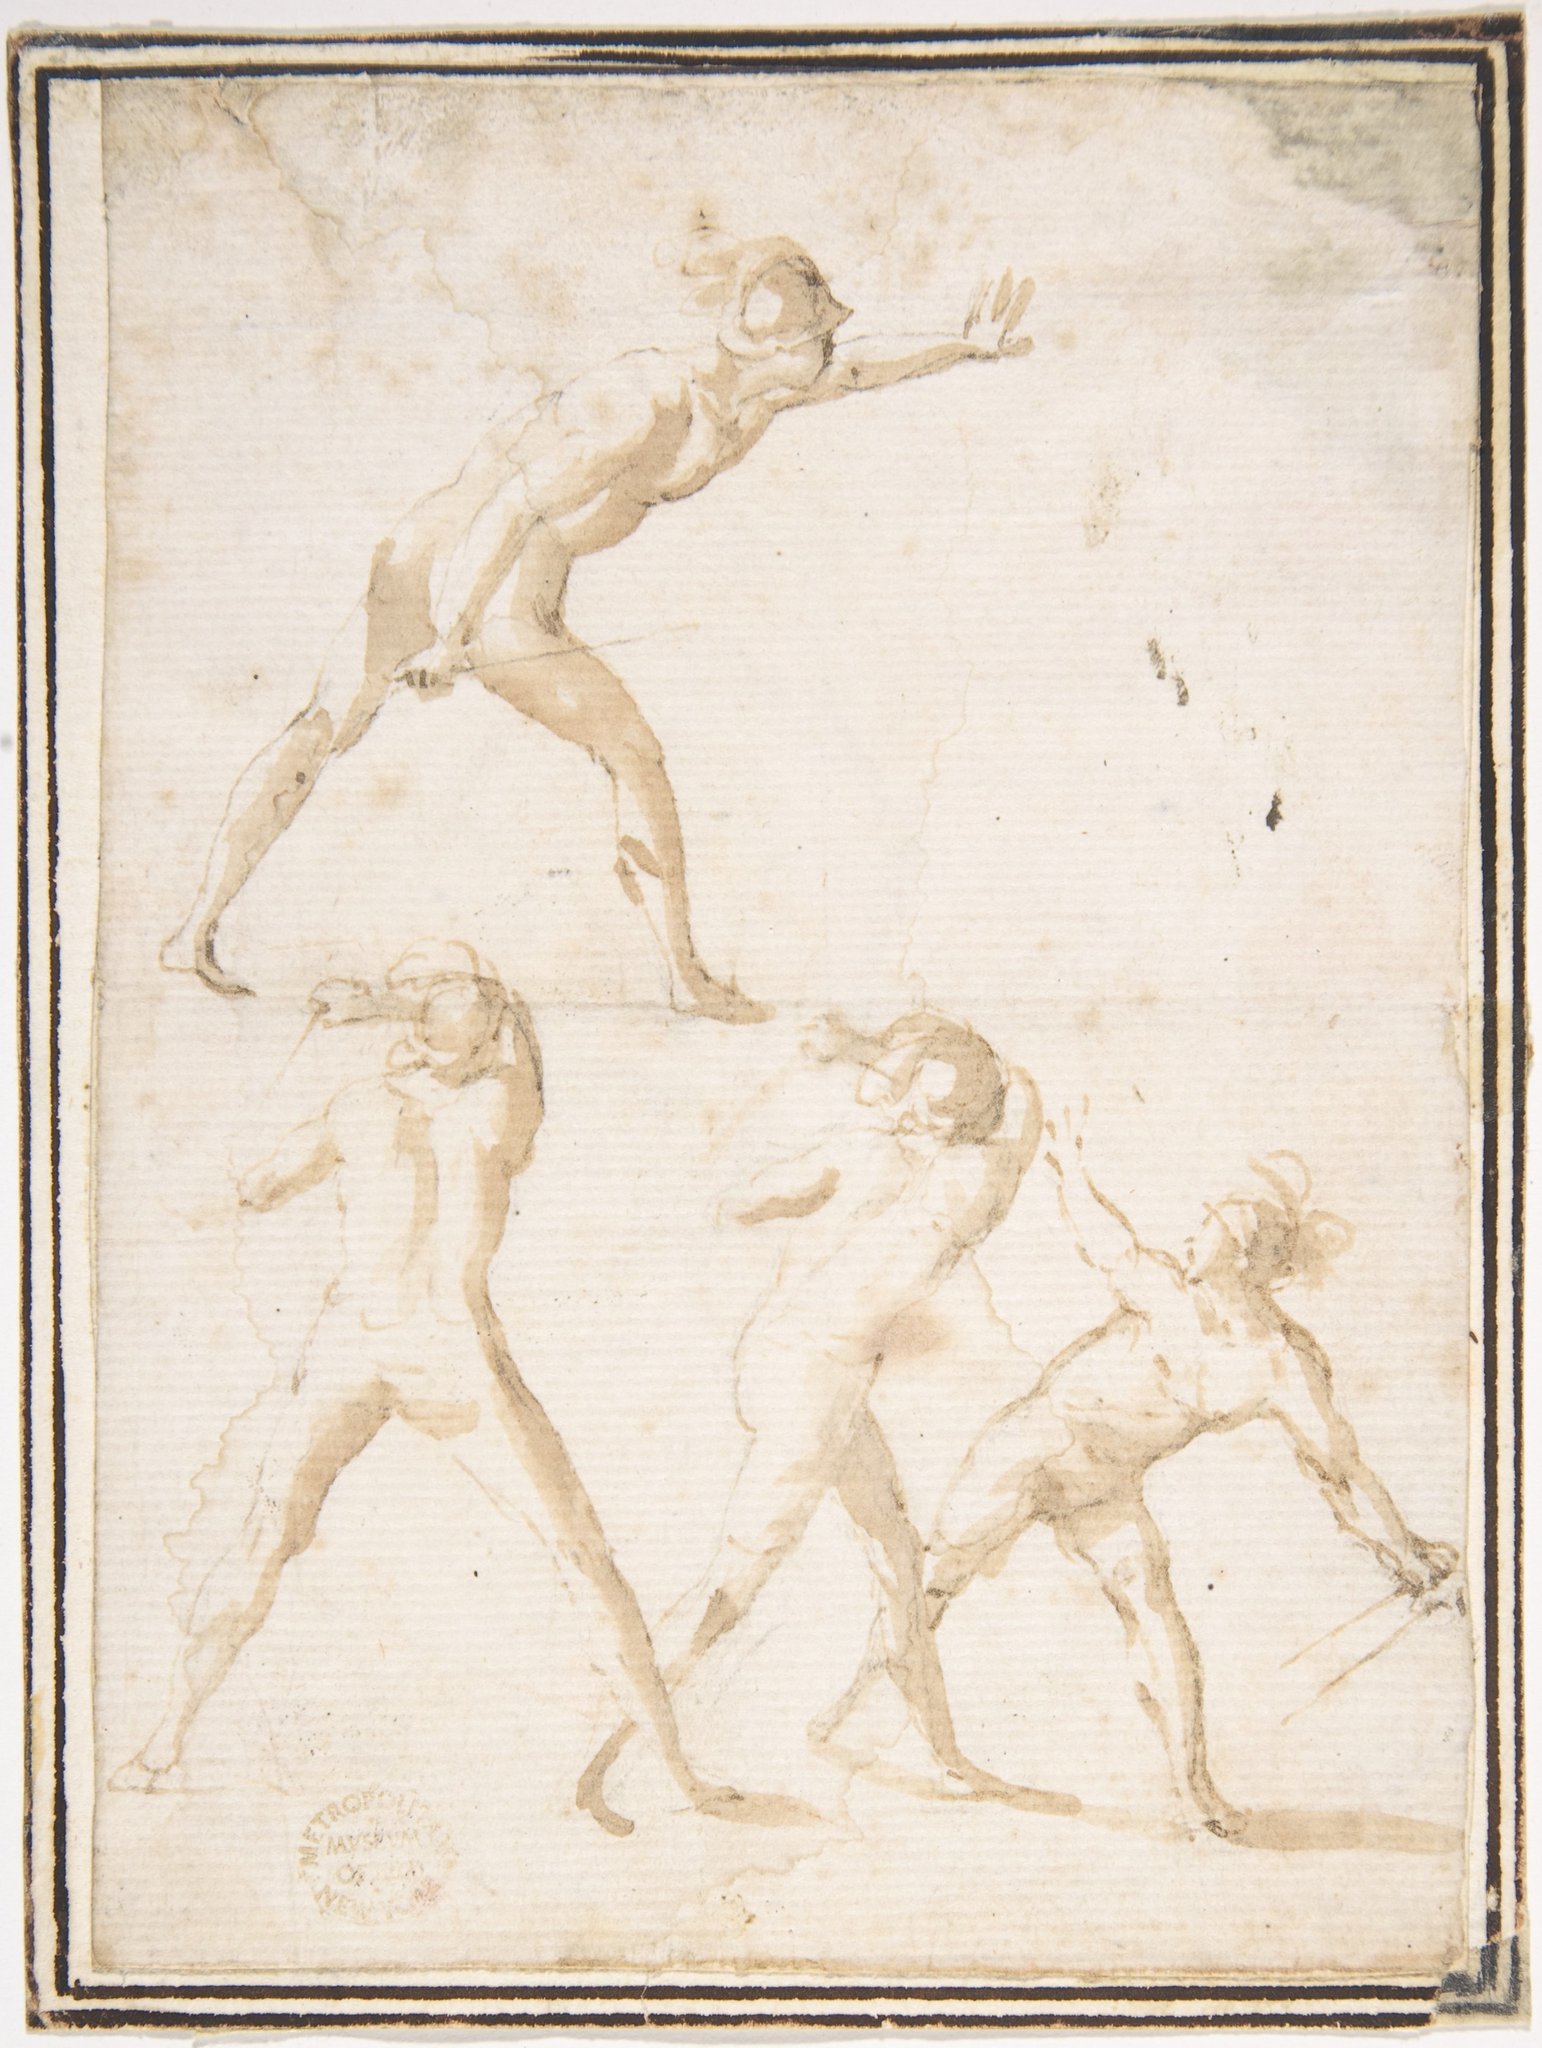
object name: drawing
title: Four Nude Warriors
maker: francesco allegrini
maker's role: artist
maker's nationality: italian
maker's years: 1615-1679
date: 1624-1663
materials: ink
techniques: pen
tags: soldiers,male nudes